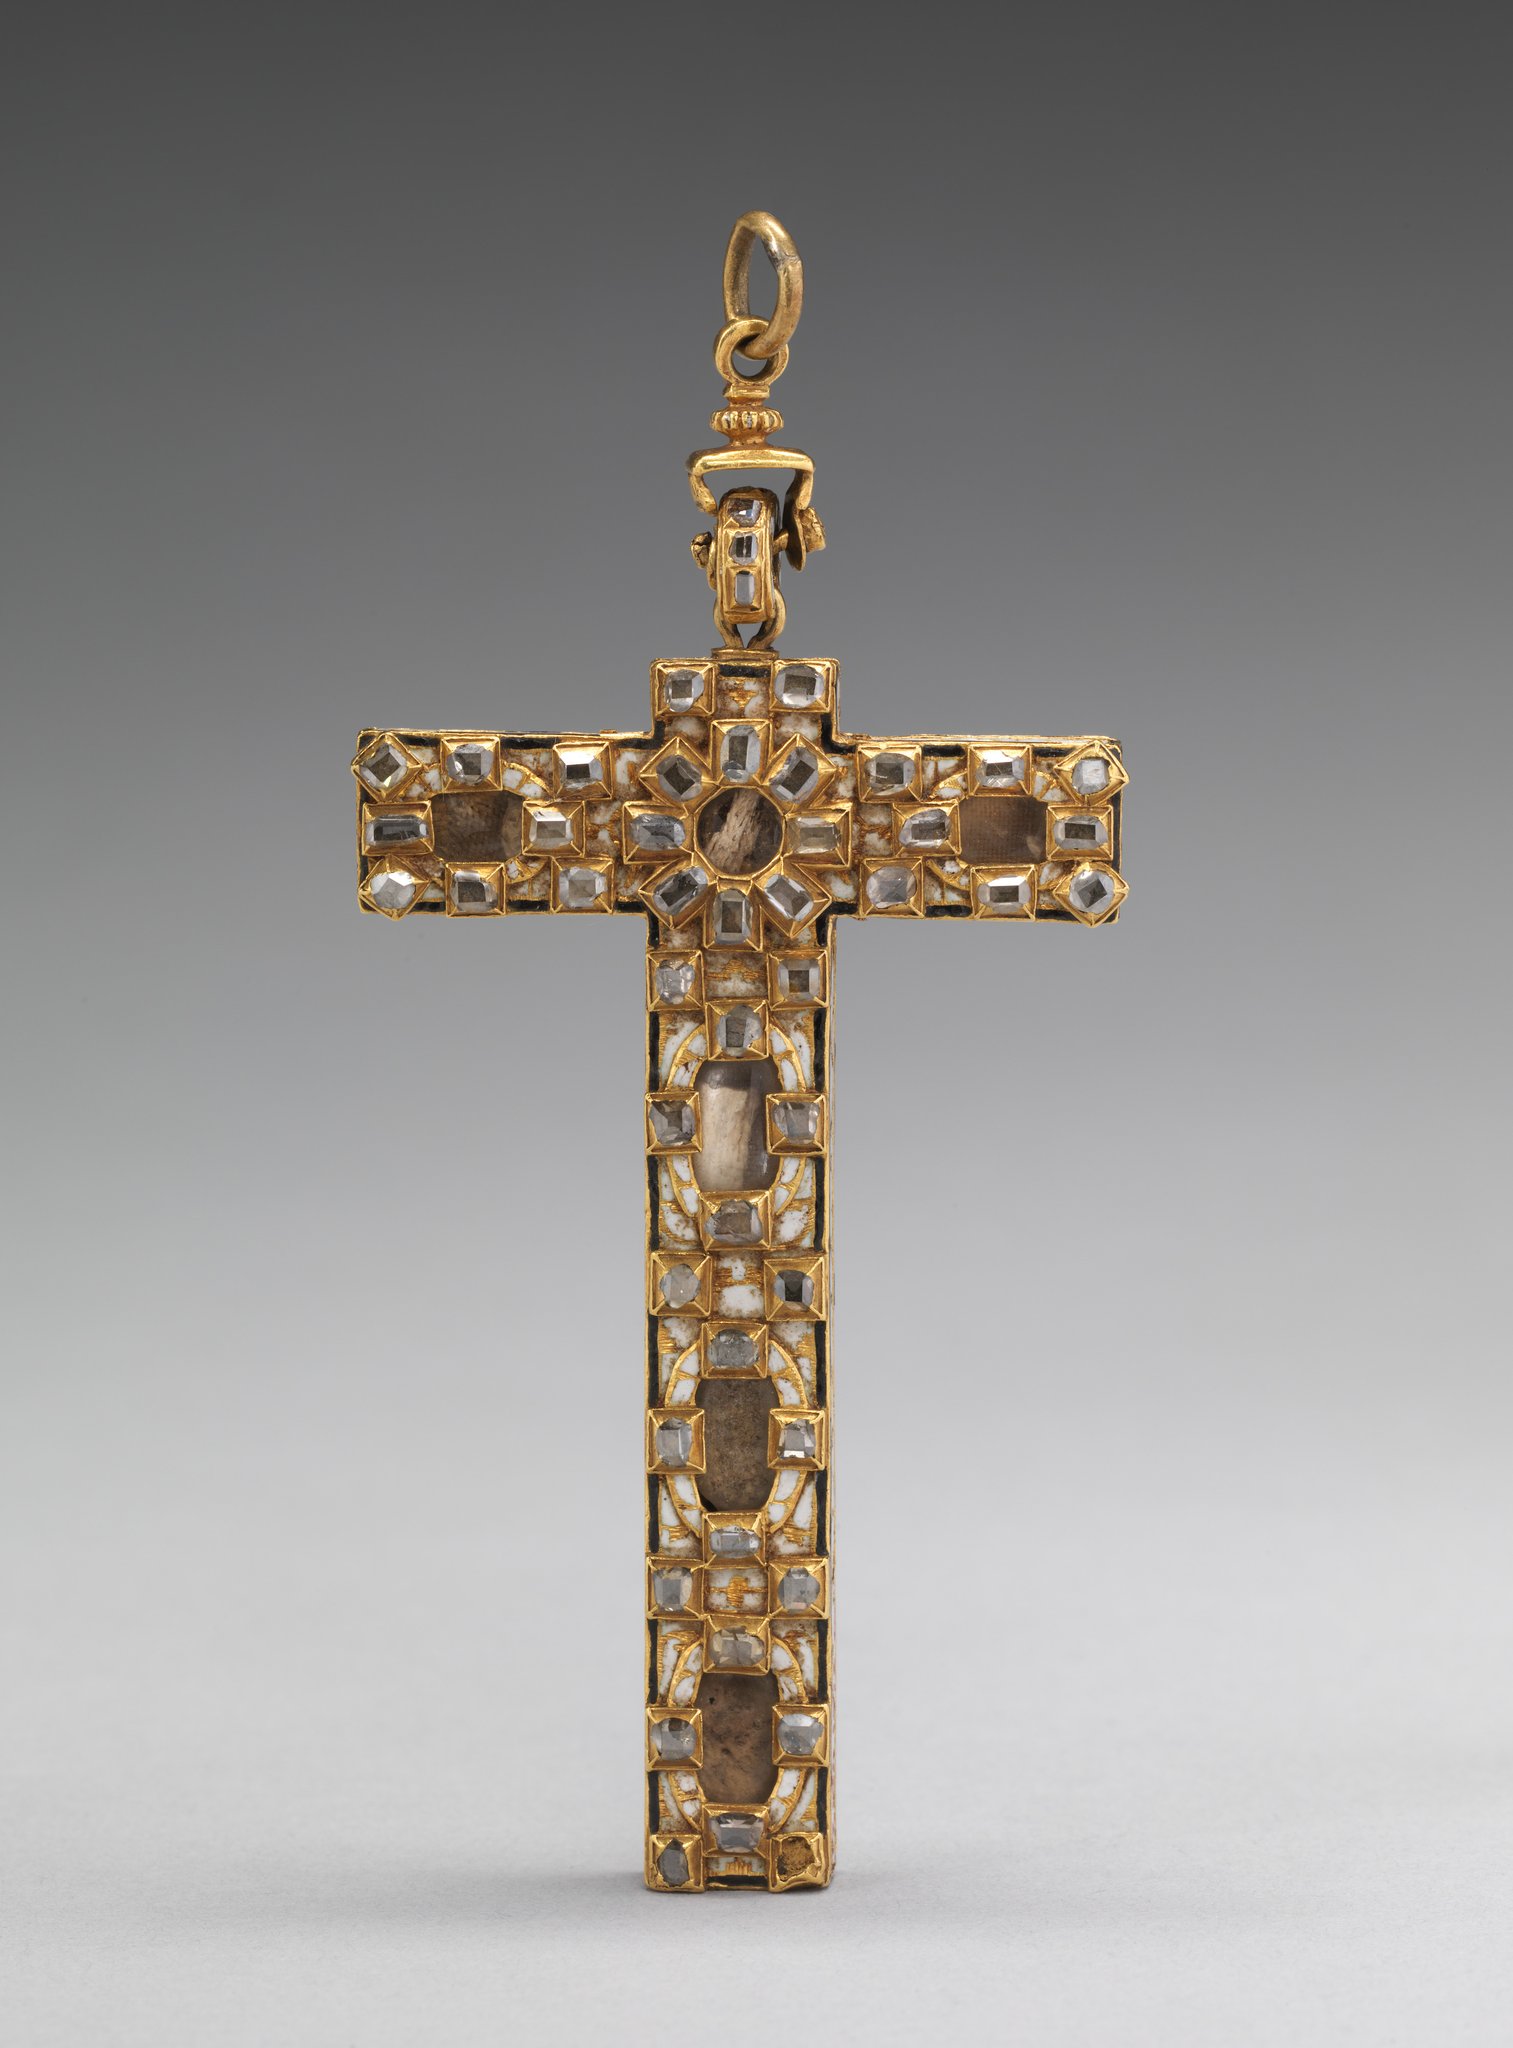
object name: reliquary cross and chain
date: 1601-1633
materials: diamond, enamel, gold